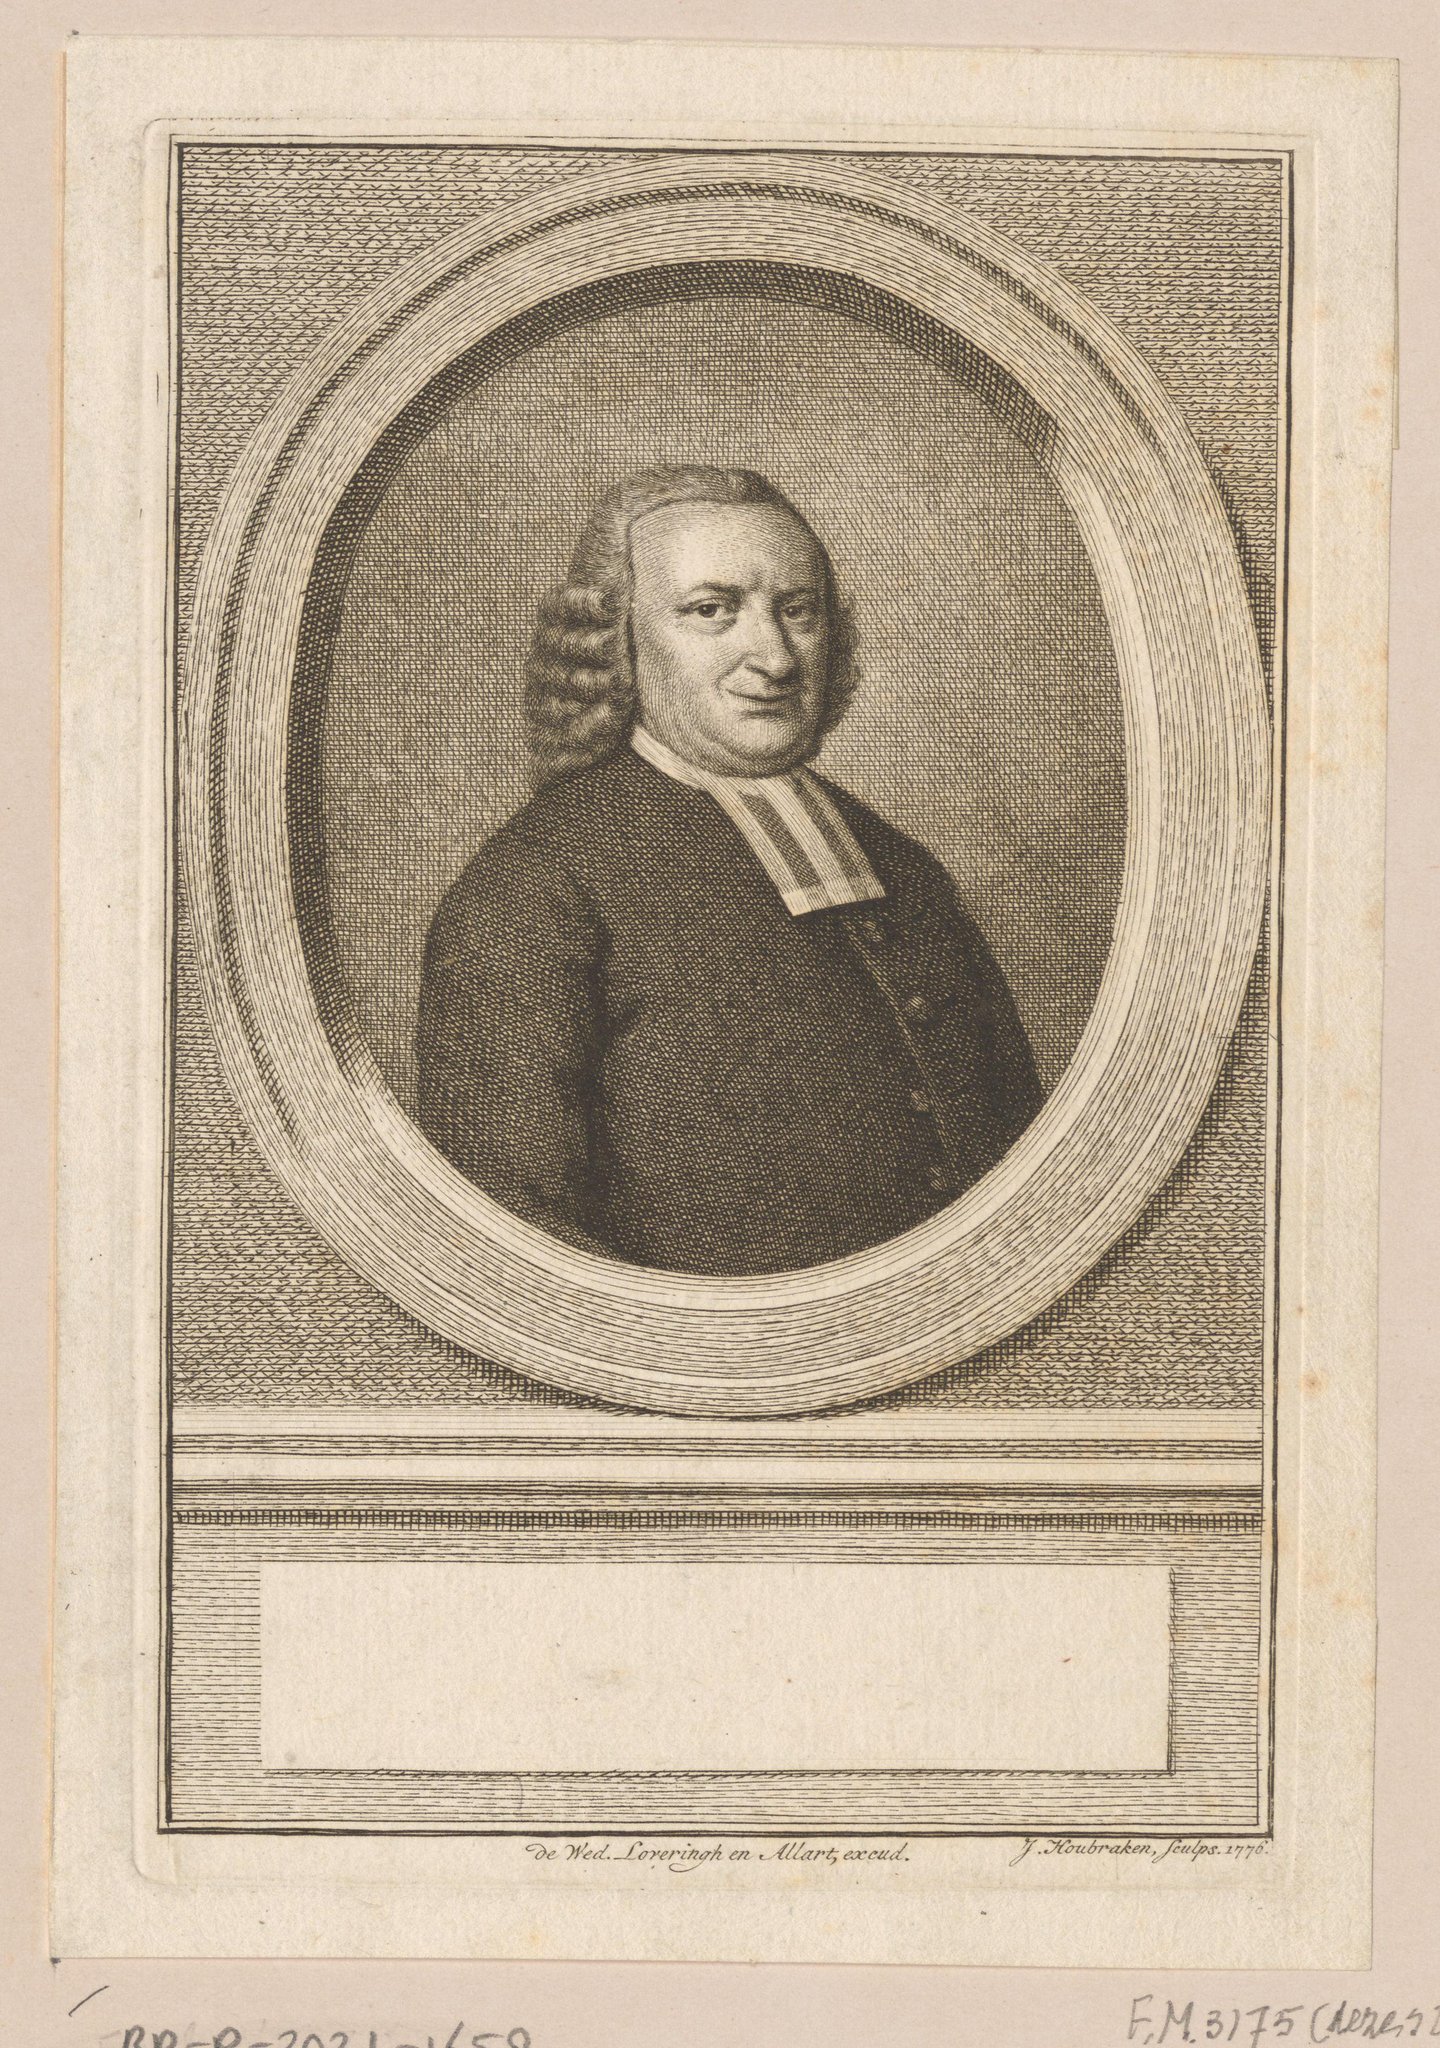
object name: print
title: Portret van George Lemke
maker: jacob houbraken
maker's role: draughtsman, print maker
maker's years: 1698-1780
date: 1776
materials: paper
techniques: engraving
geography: northern netherlands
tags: ornament ~ medallion, historical persons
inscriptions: collector's mark: Lugt 964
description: Latere staat gebruikt in: Iperen, Josua van. Kerkelyke historie van het psalm-gezang der christenen (...). Amsterdam: Johannes Allart, 1778, dl. 2.